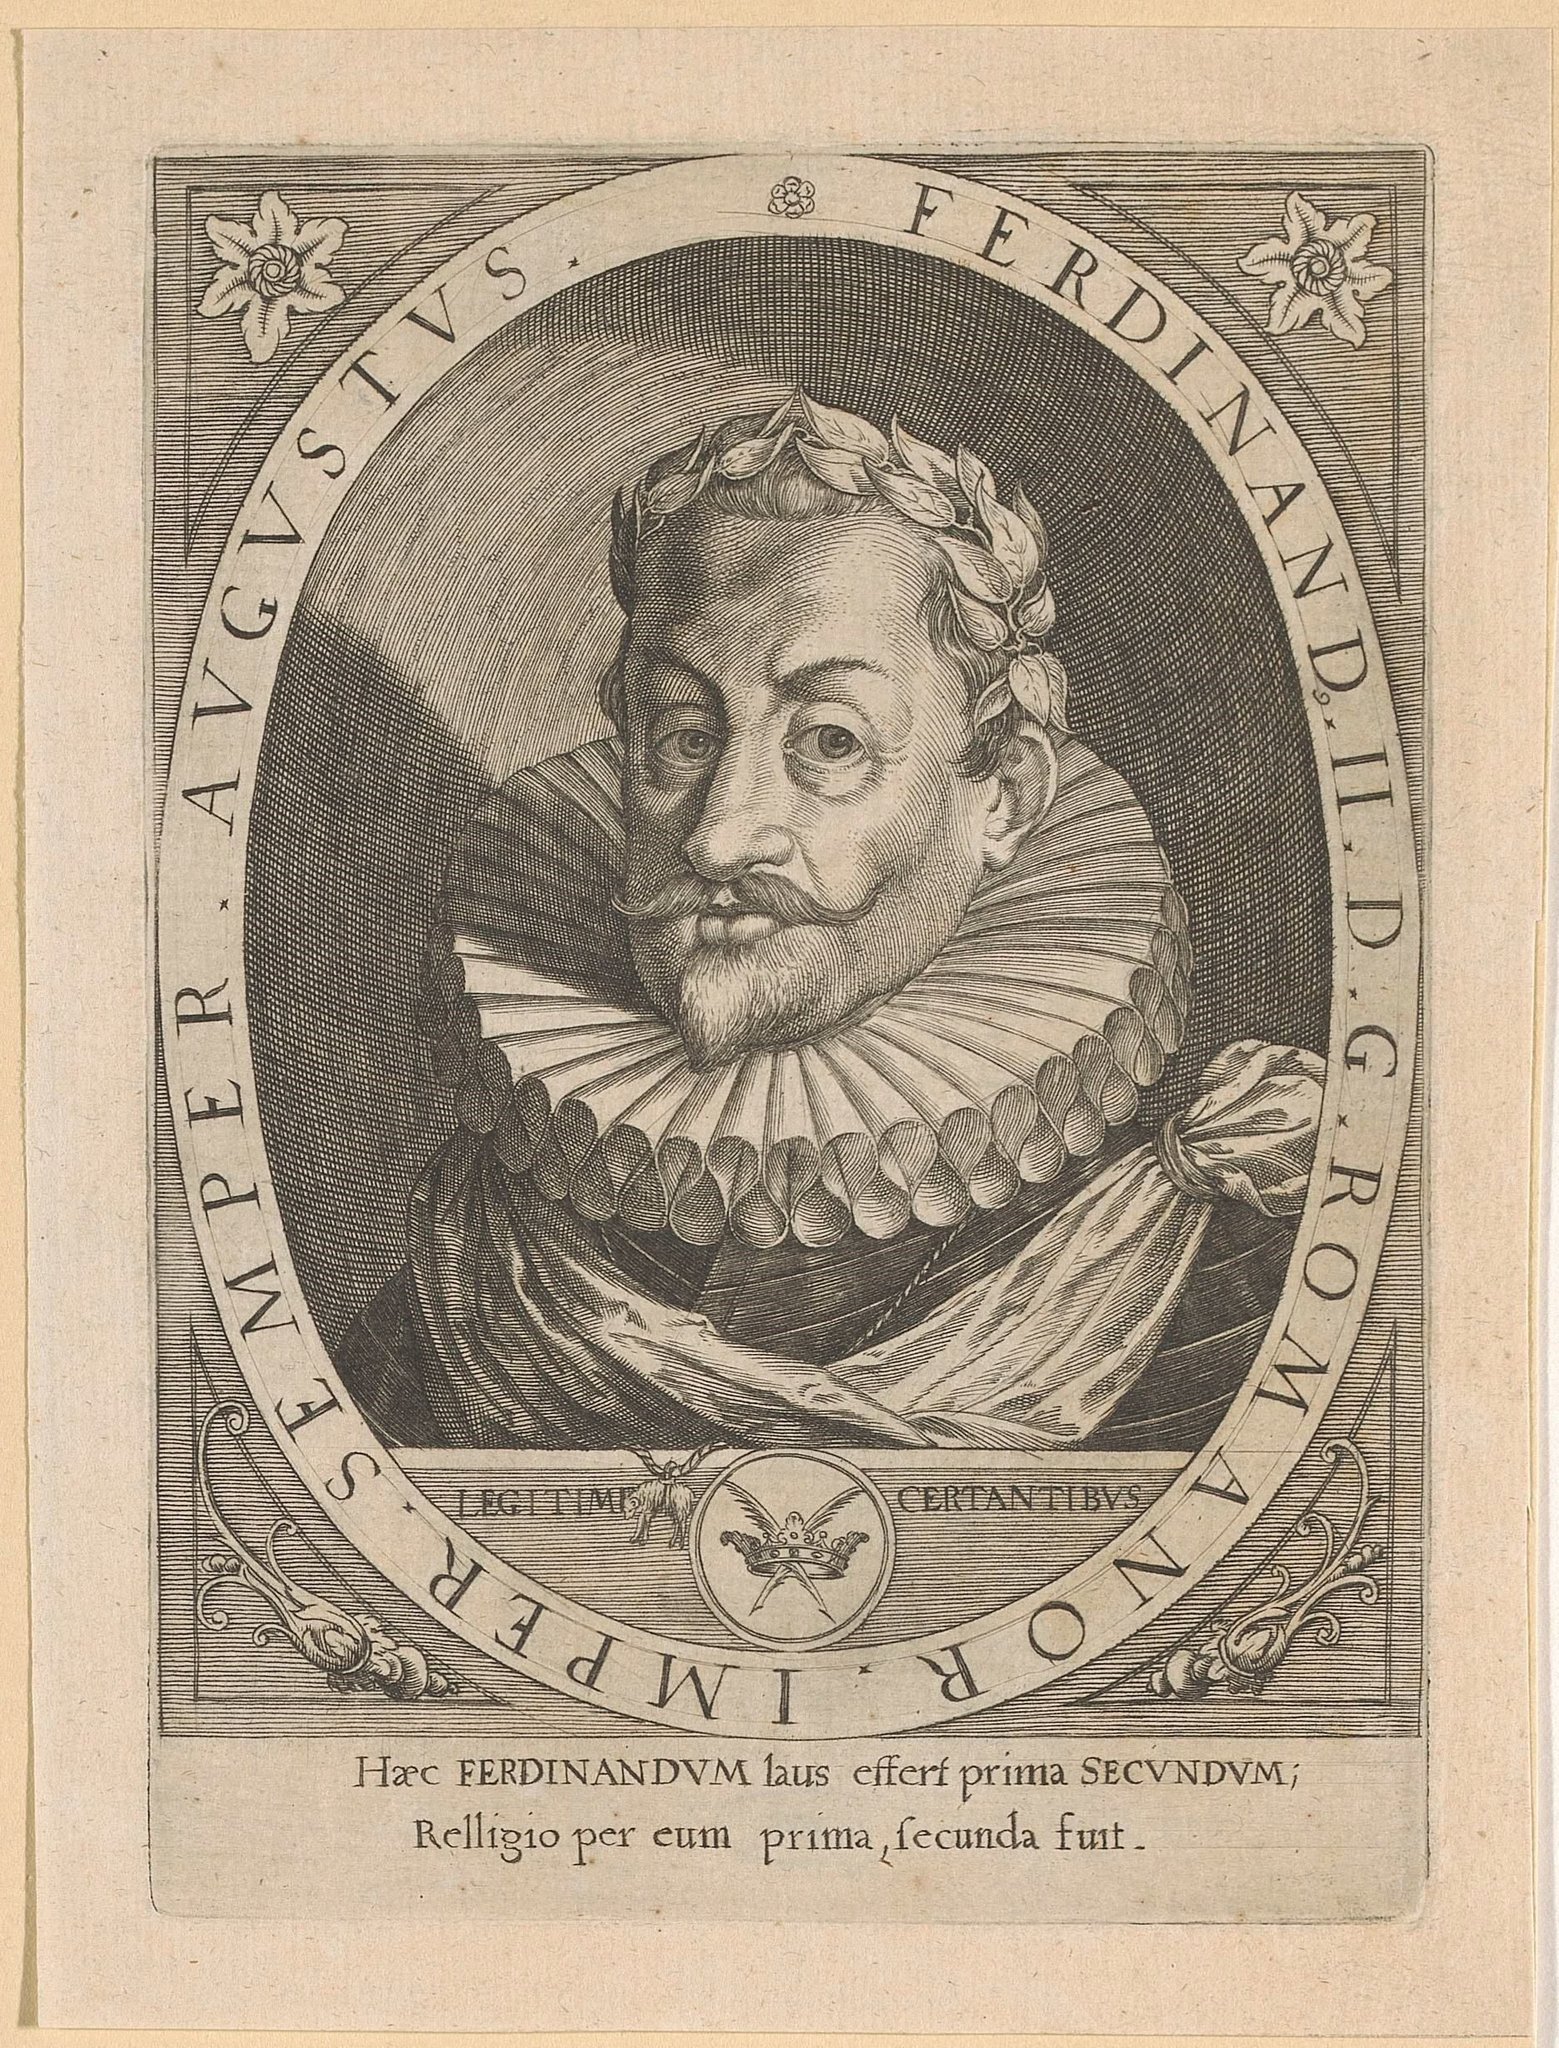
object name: print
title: Ferdinandi I. II. III. IV.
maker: johann caspar dooms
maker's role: print maker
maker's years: 1597-1685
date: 1650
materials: paper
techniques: engraving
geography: prague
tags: vienna, ferdinand ii (duits keizer), crown (symbol of sovereignty), quill, historical persons, ruler, sovereign, knighthood order of the golden fleece - insignia of a knighthood order, e.g.: badge, chain (with name of order), crowning with laurel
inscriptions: collector's mark: Lugt 2228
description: Een kroon doorstoken met twee pennen onder het portret. Met onderschrift in het Latijn.